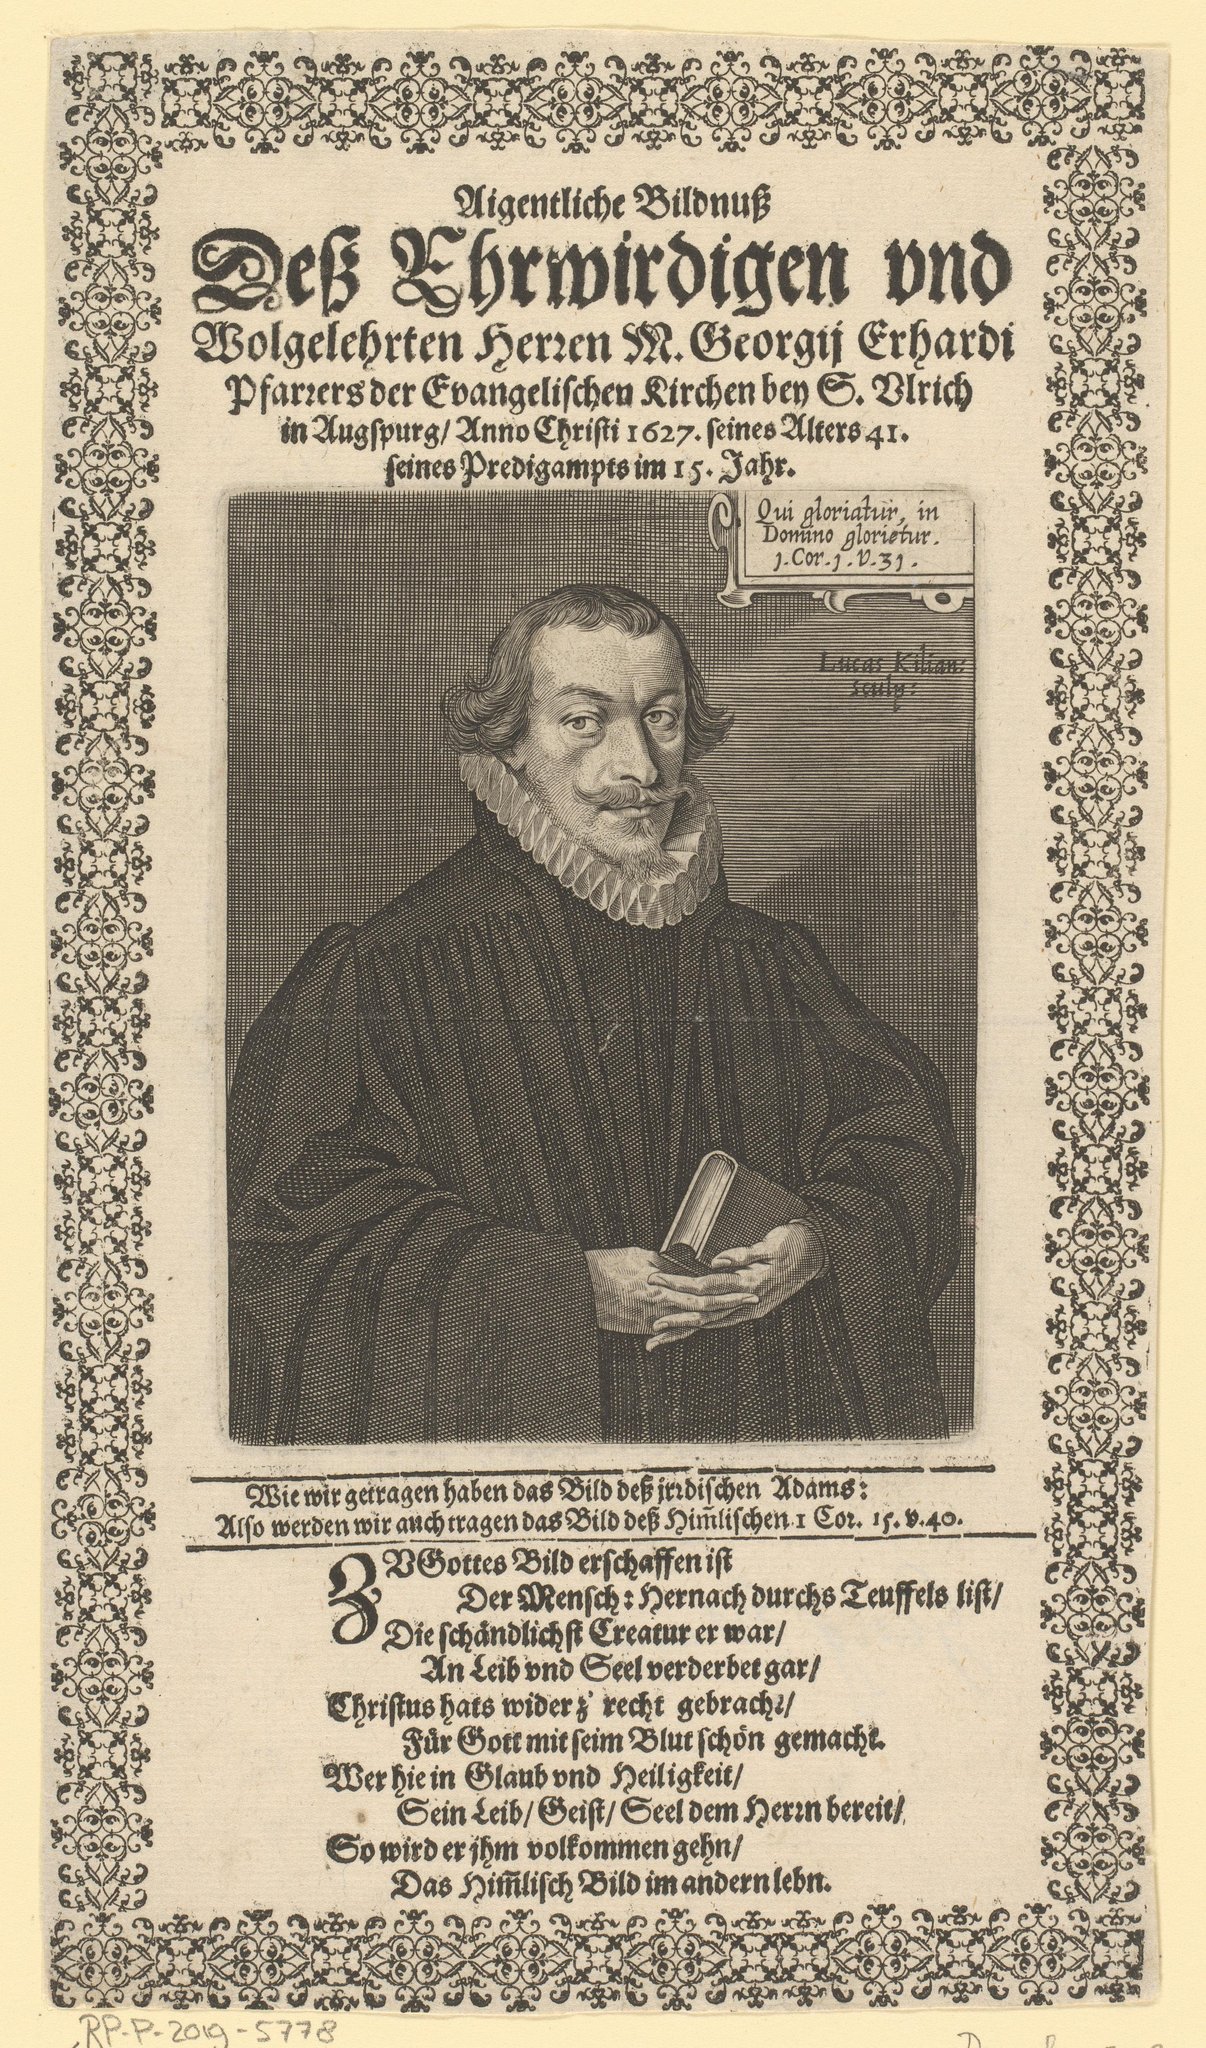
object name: print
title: Eigendliche Bildnuß deß Ehrwürdigen Wolgelehzten Herzn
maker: lucas kilian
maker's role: draughtsman, print maker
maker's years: 1579-1637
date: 1627-1637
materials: paper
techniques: engraving, letterpress printing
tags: historical persons, book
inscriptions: watermark, collector's mark: Lugt 2228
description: Onder het portret een Bijbelcitaat en daaronder een tienregellig vers.